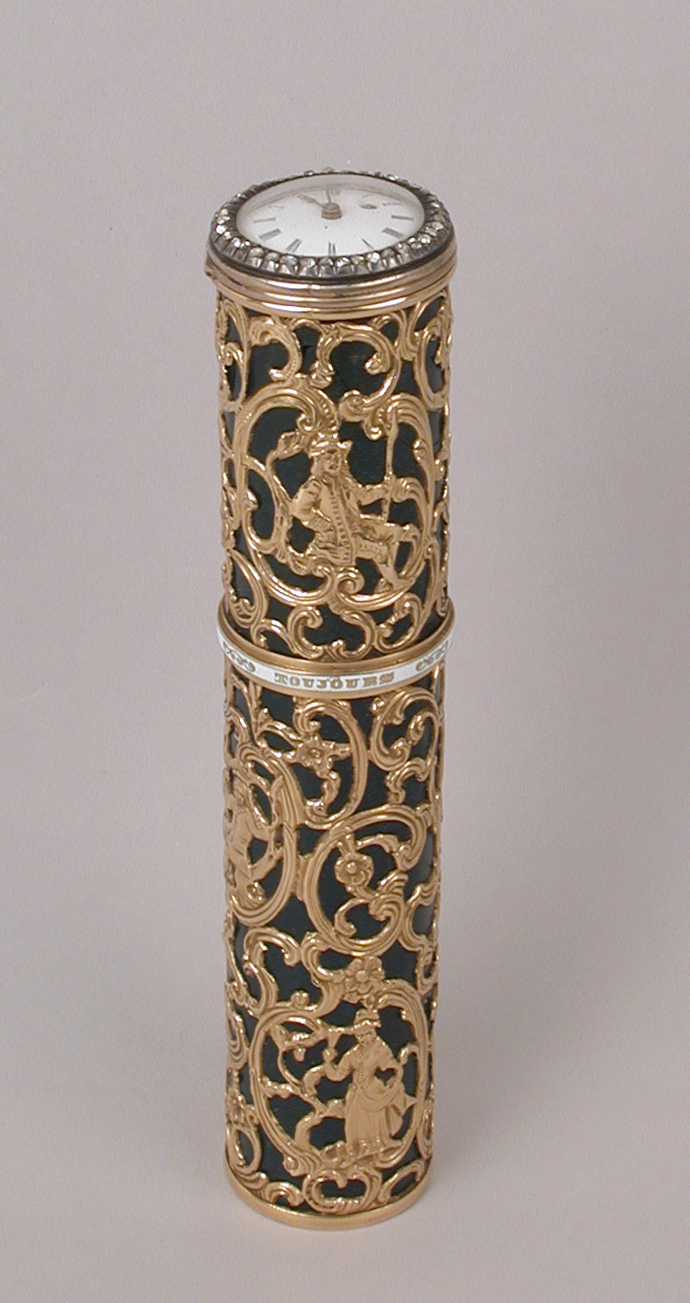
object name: watch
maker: abraham-louis bréguet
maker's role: maker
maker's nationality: swiss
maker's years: 1747-1823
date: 1751-1800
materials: enamel, gold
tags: human figures